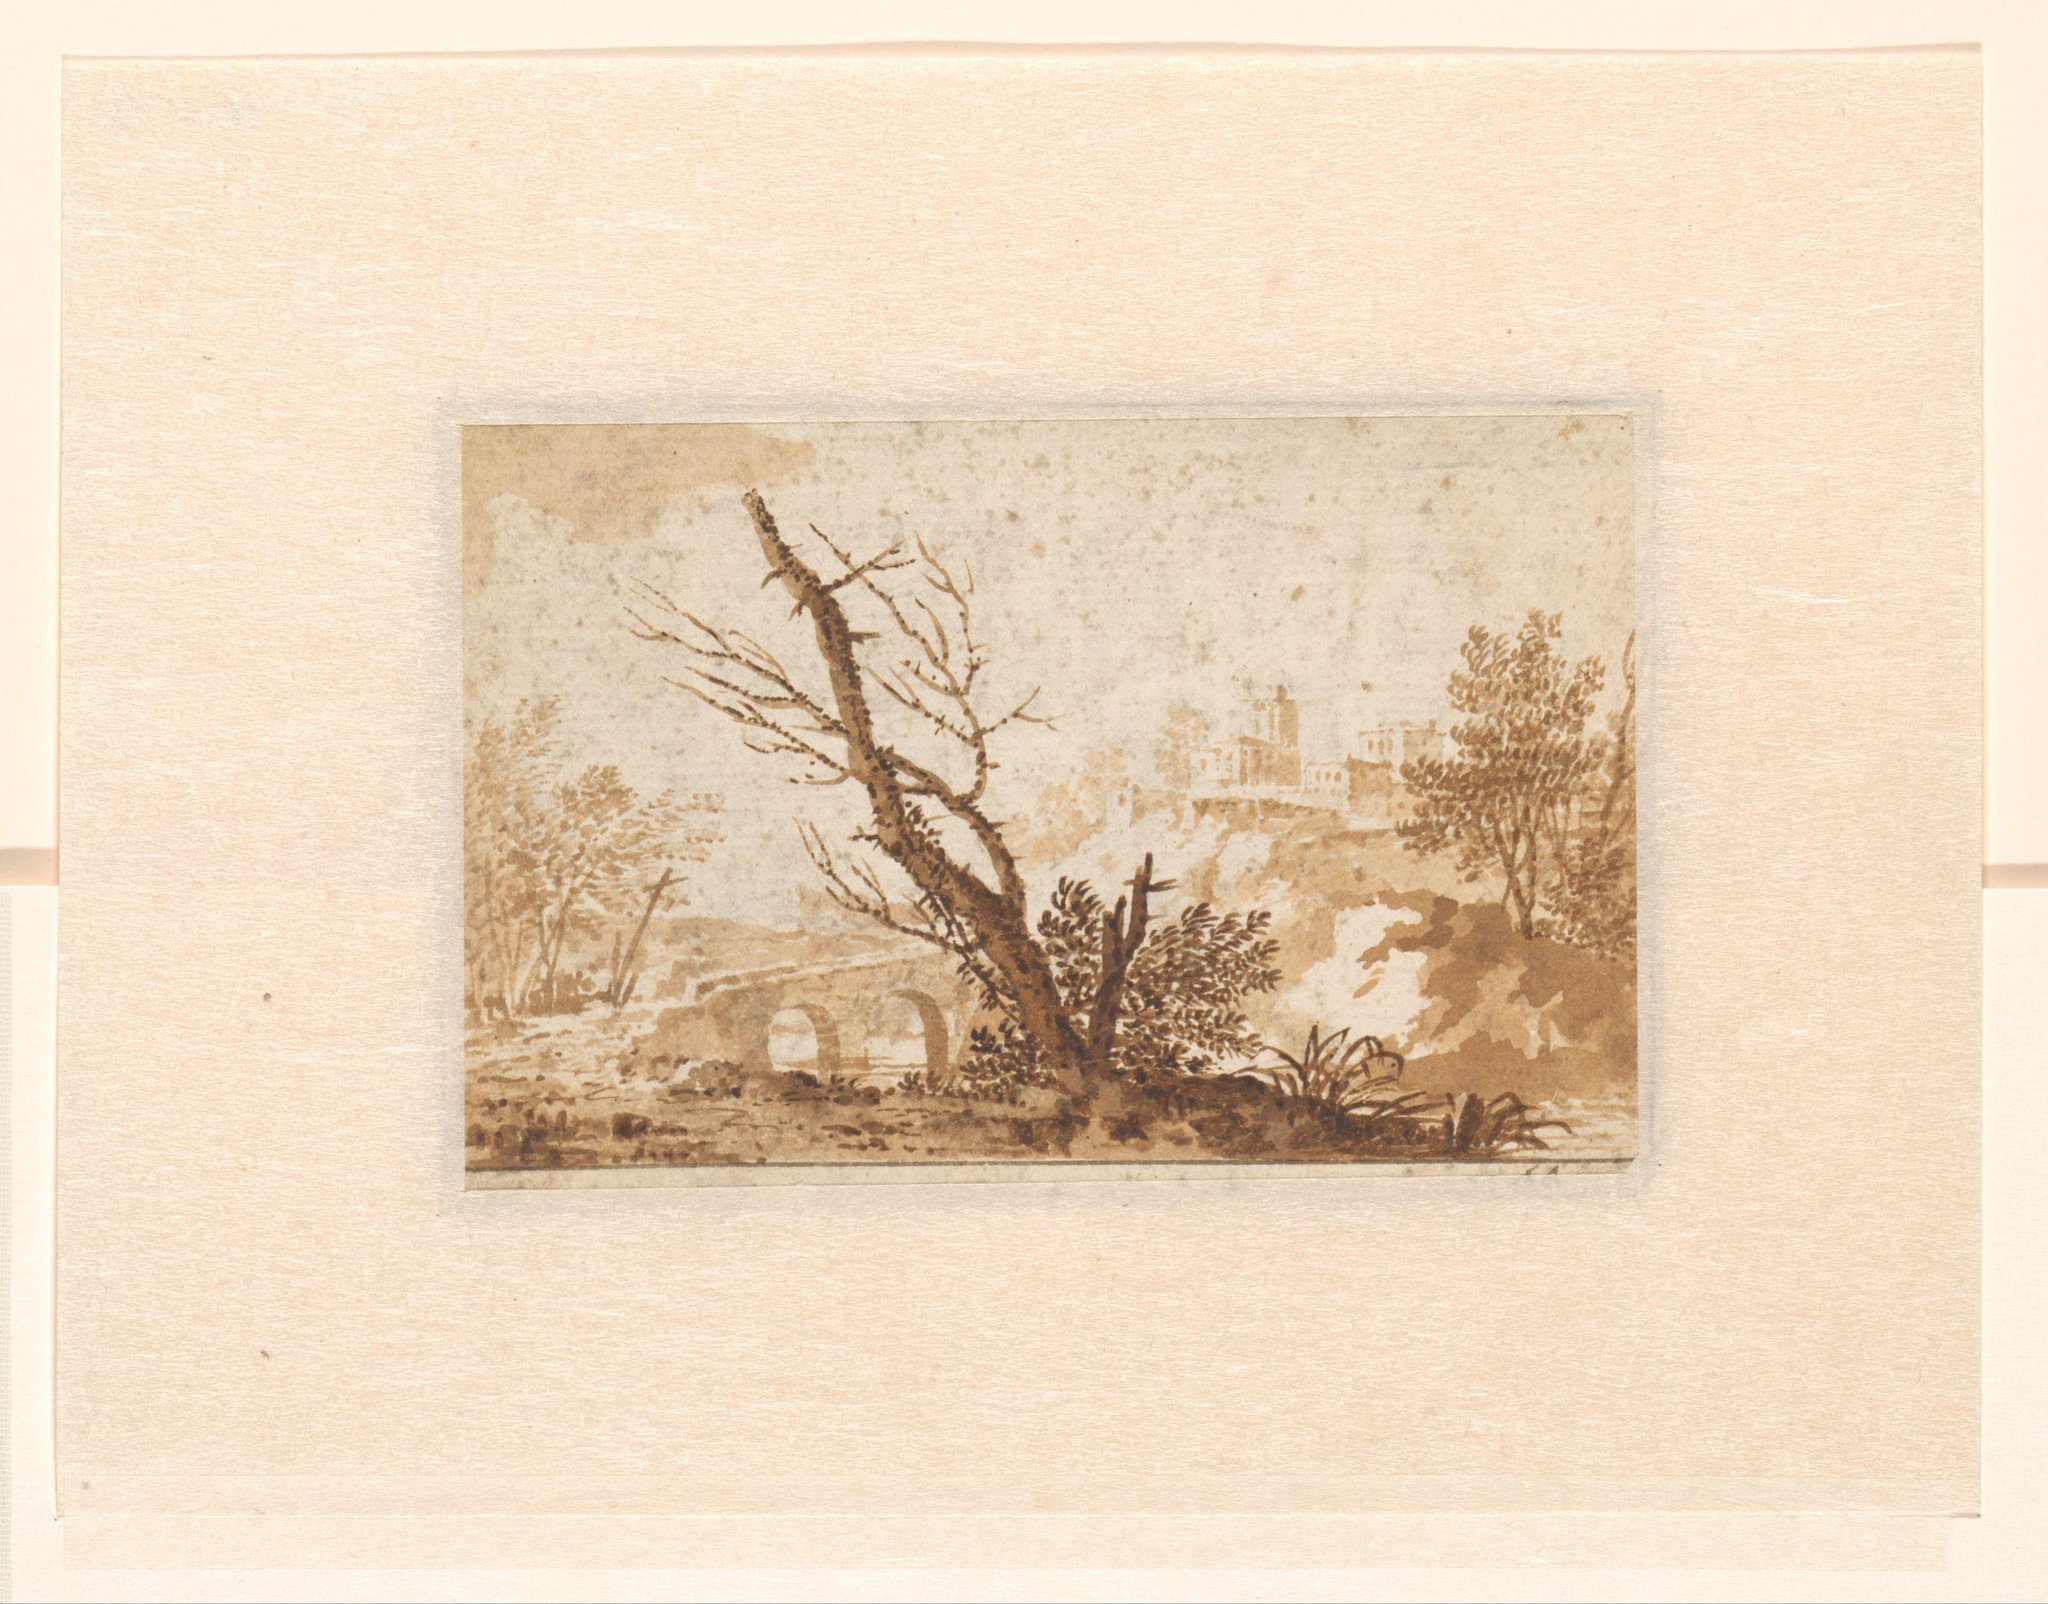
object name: drawing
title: Italiaans landschap met boom, een brug en enkele gebouwen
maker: johannes petrus van horstok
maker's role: draughtsman, painter, print maker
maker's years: 1745-1825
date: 1755-1825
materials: paper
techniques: brush